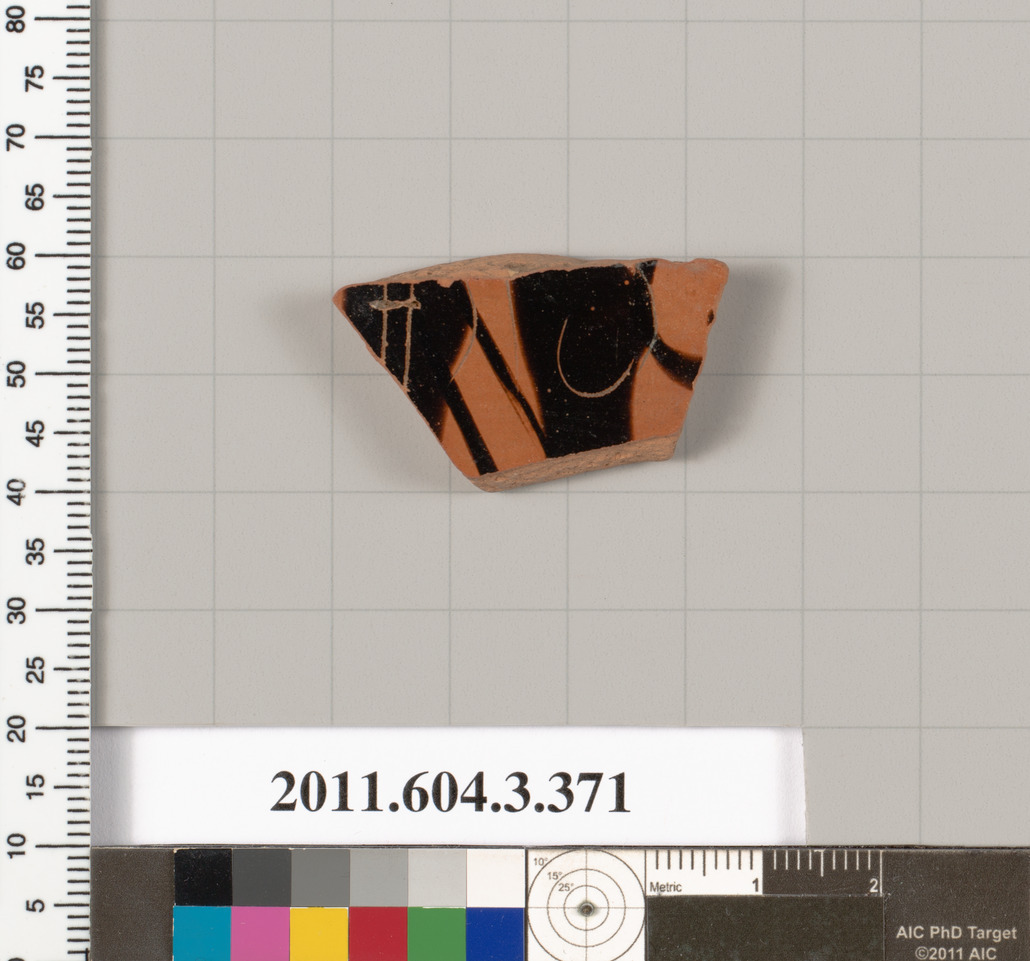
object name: neck amphora fragment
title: Terracotta fragment of a neck-amphora (jar)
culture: greek, attic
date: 525-501 BCE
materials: terracotta